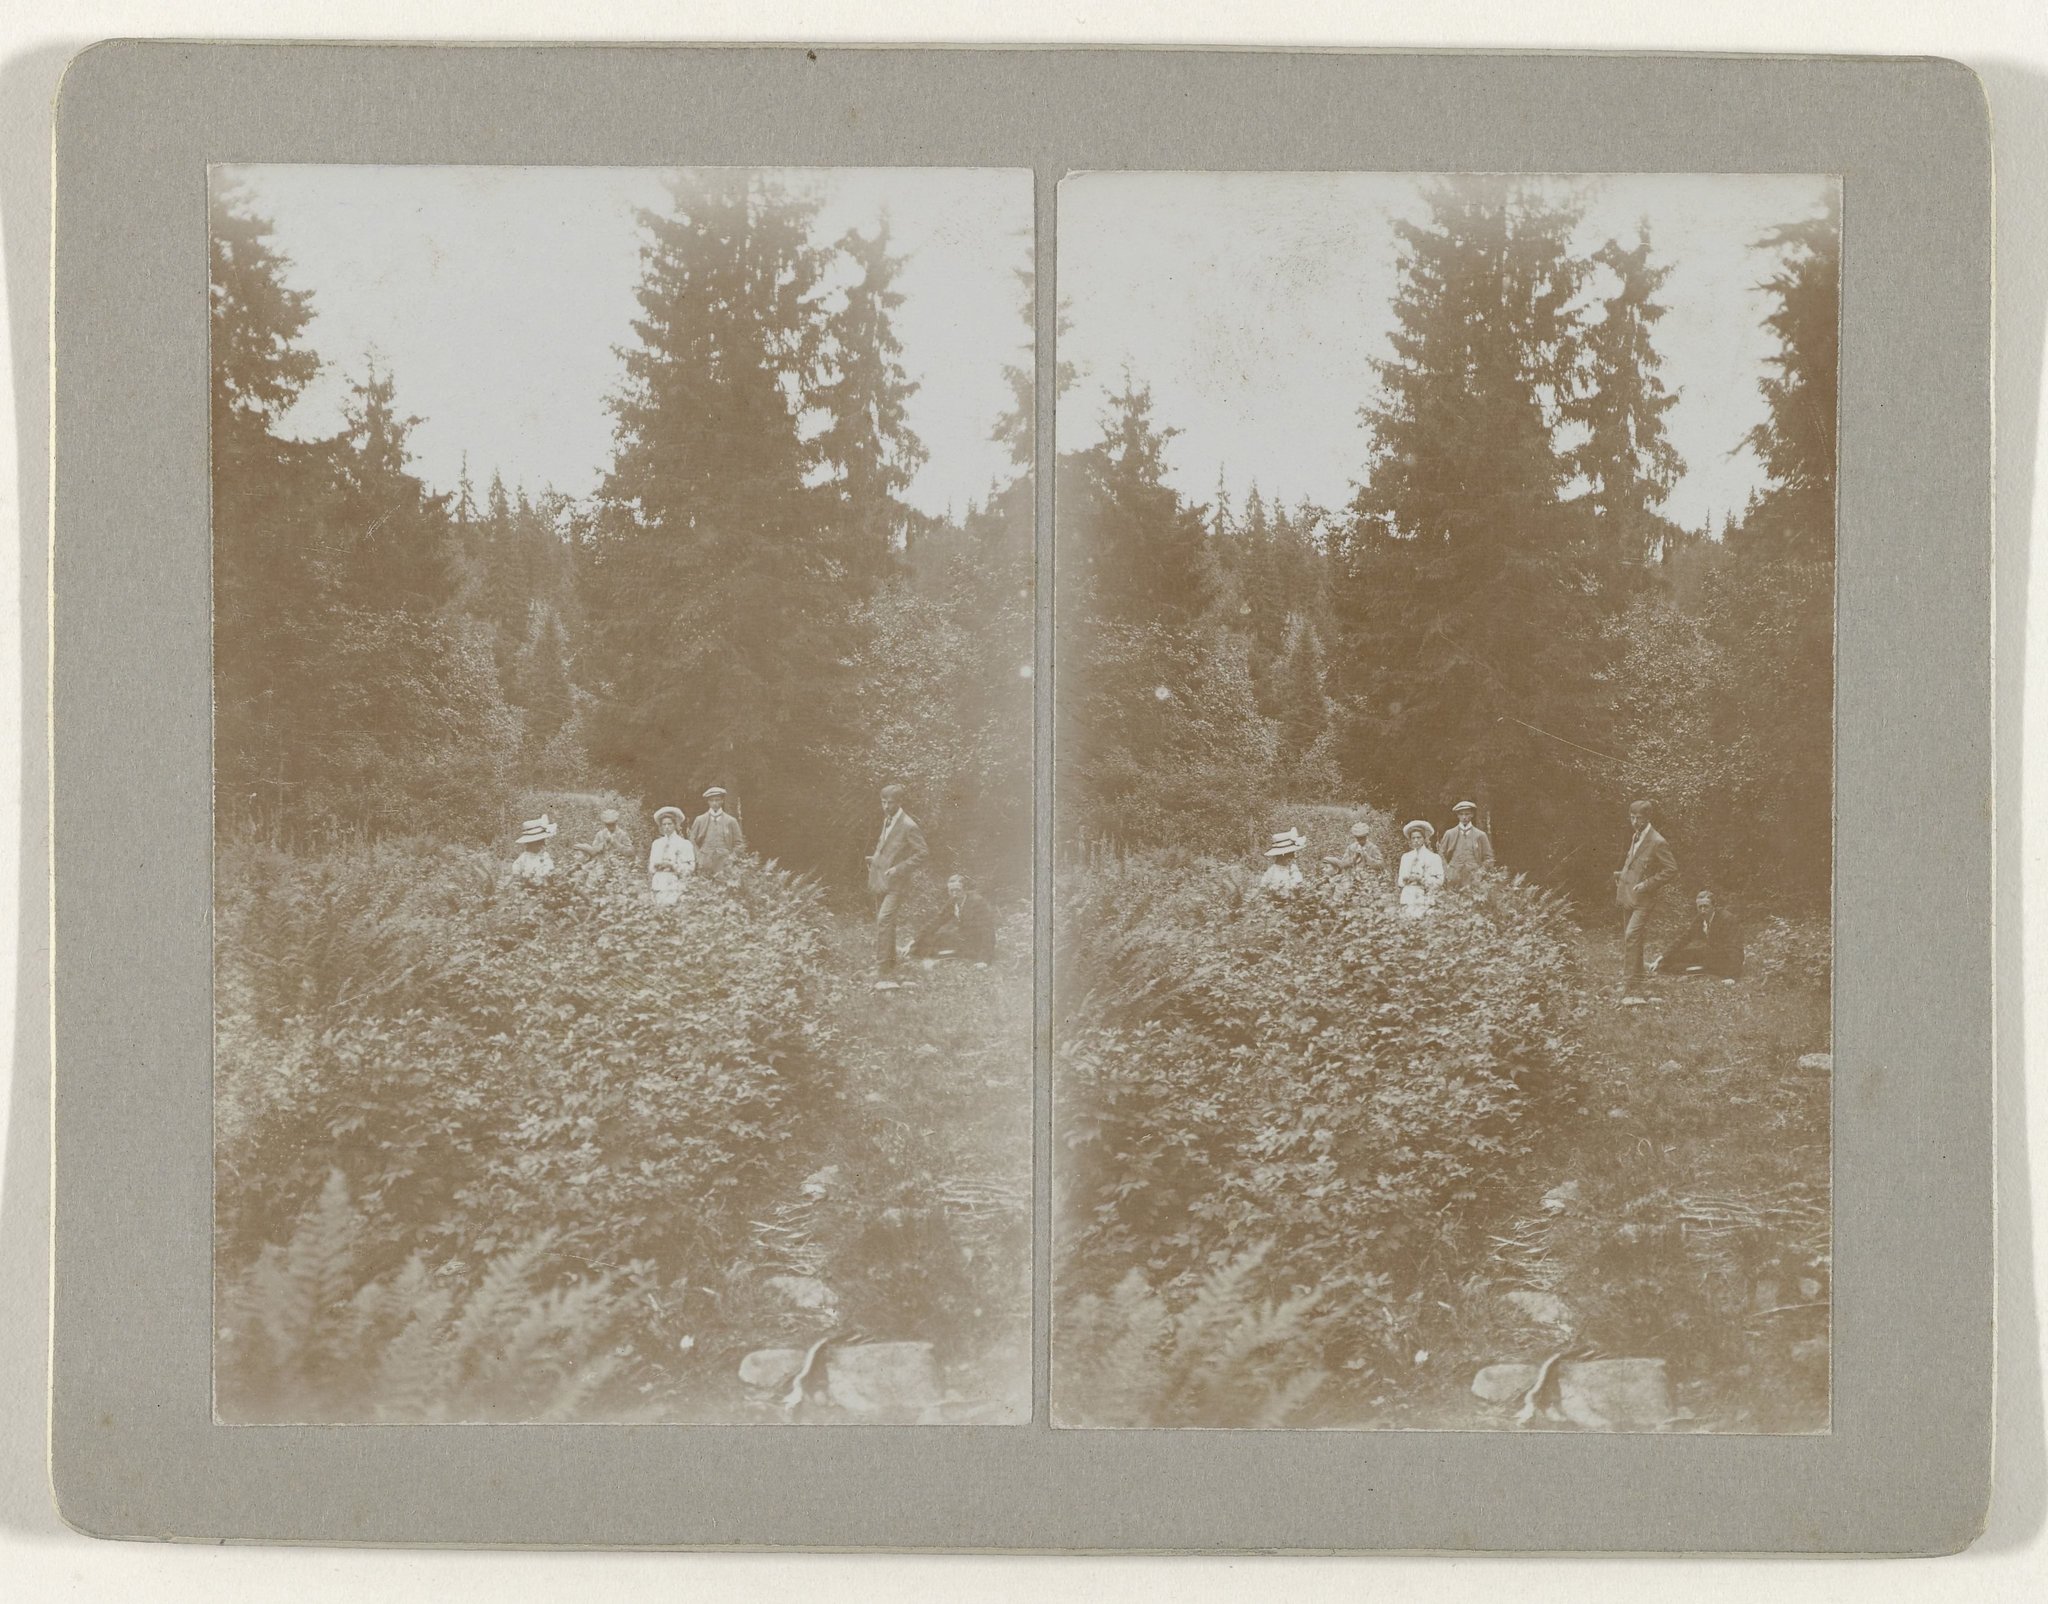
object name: stereograph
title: Noorwegen 1909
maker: geldolph adriaan kessler (dolph)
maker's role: fotograaf, industrieel, voetballer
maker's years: 1884-1945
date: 1909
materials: paper, photographic support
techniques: collodion silver print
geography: austria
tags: norway